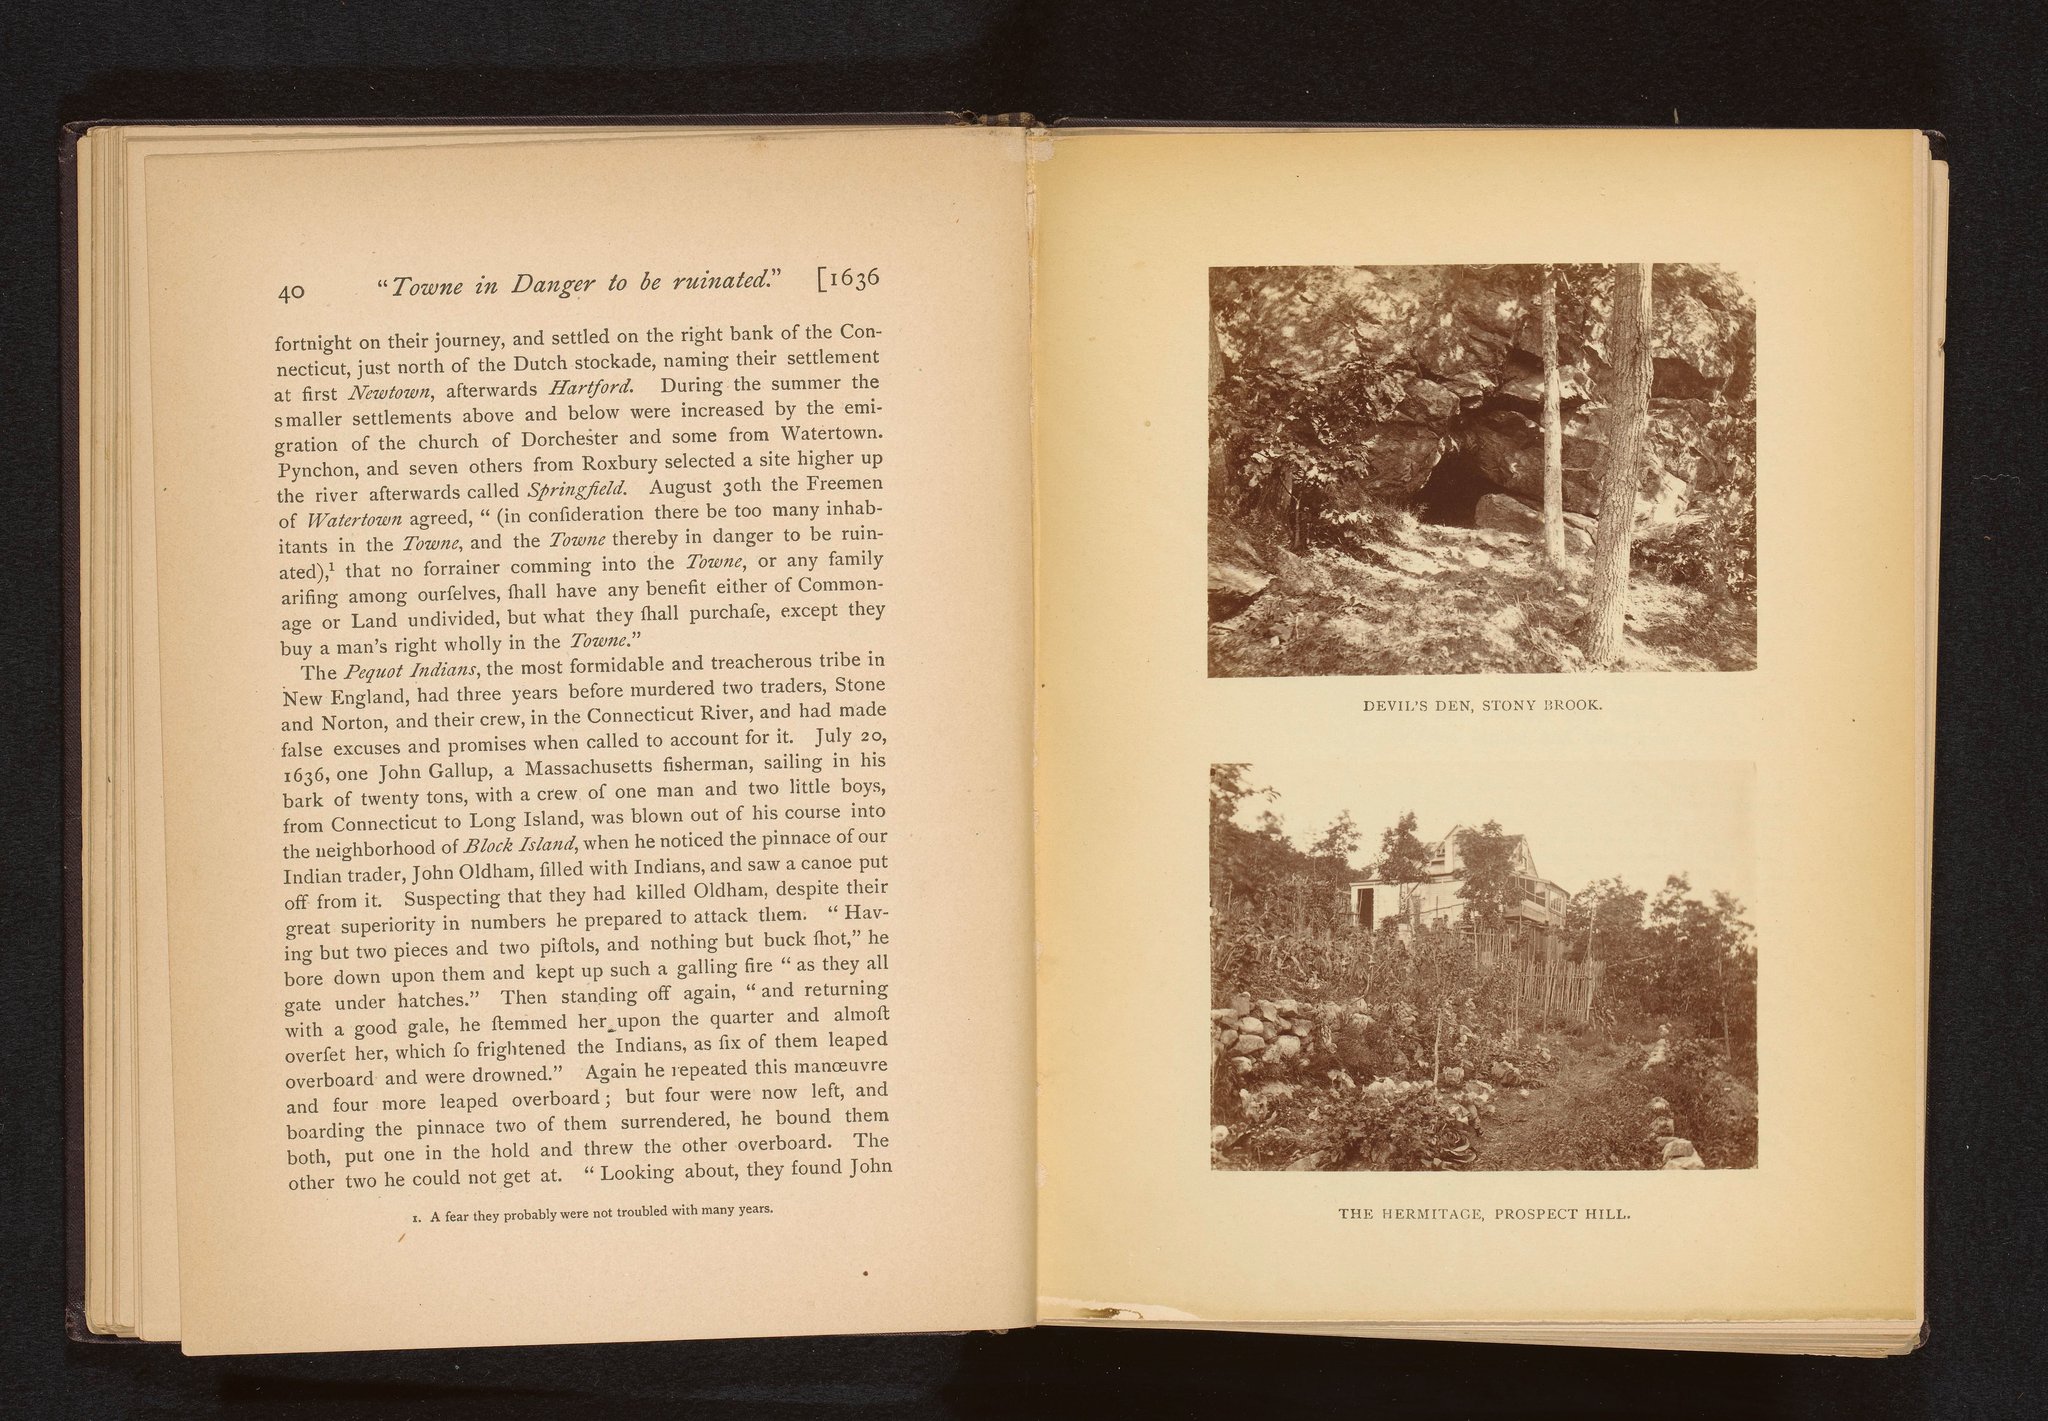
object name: photograph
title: Gezicht op Devil's Den in Stony Brook in Norfolk, Massachusetts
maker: thomas r. lewis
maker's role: publisher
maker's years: 1845-1901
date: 1874-1879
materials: photographic support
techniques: albumen print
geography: norfolk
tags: rock-formations